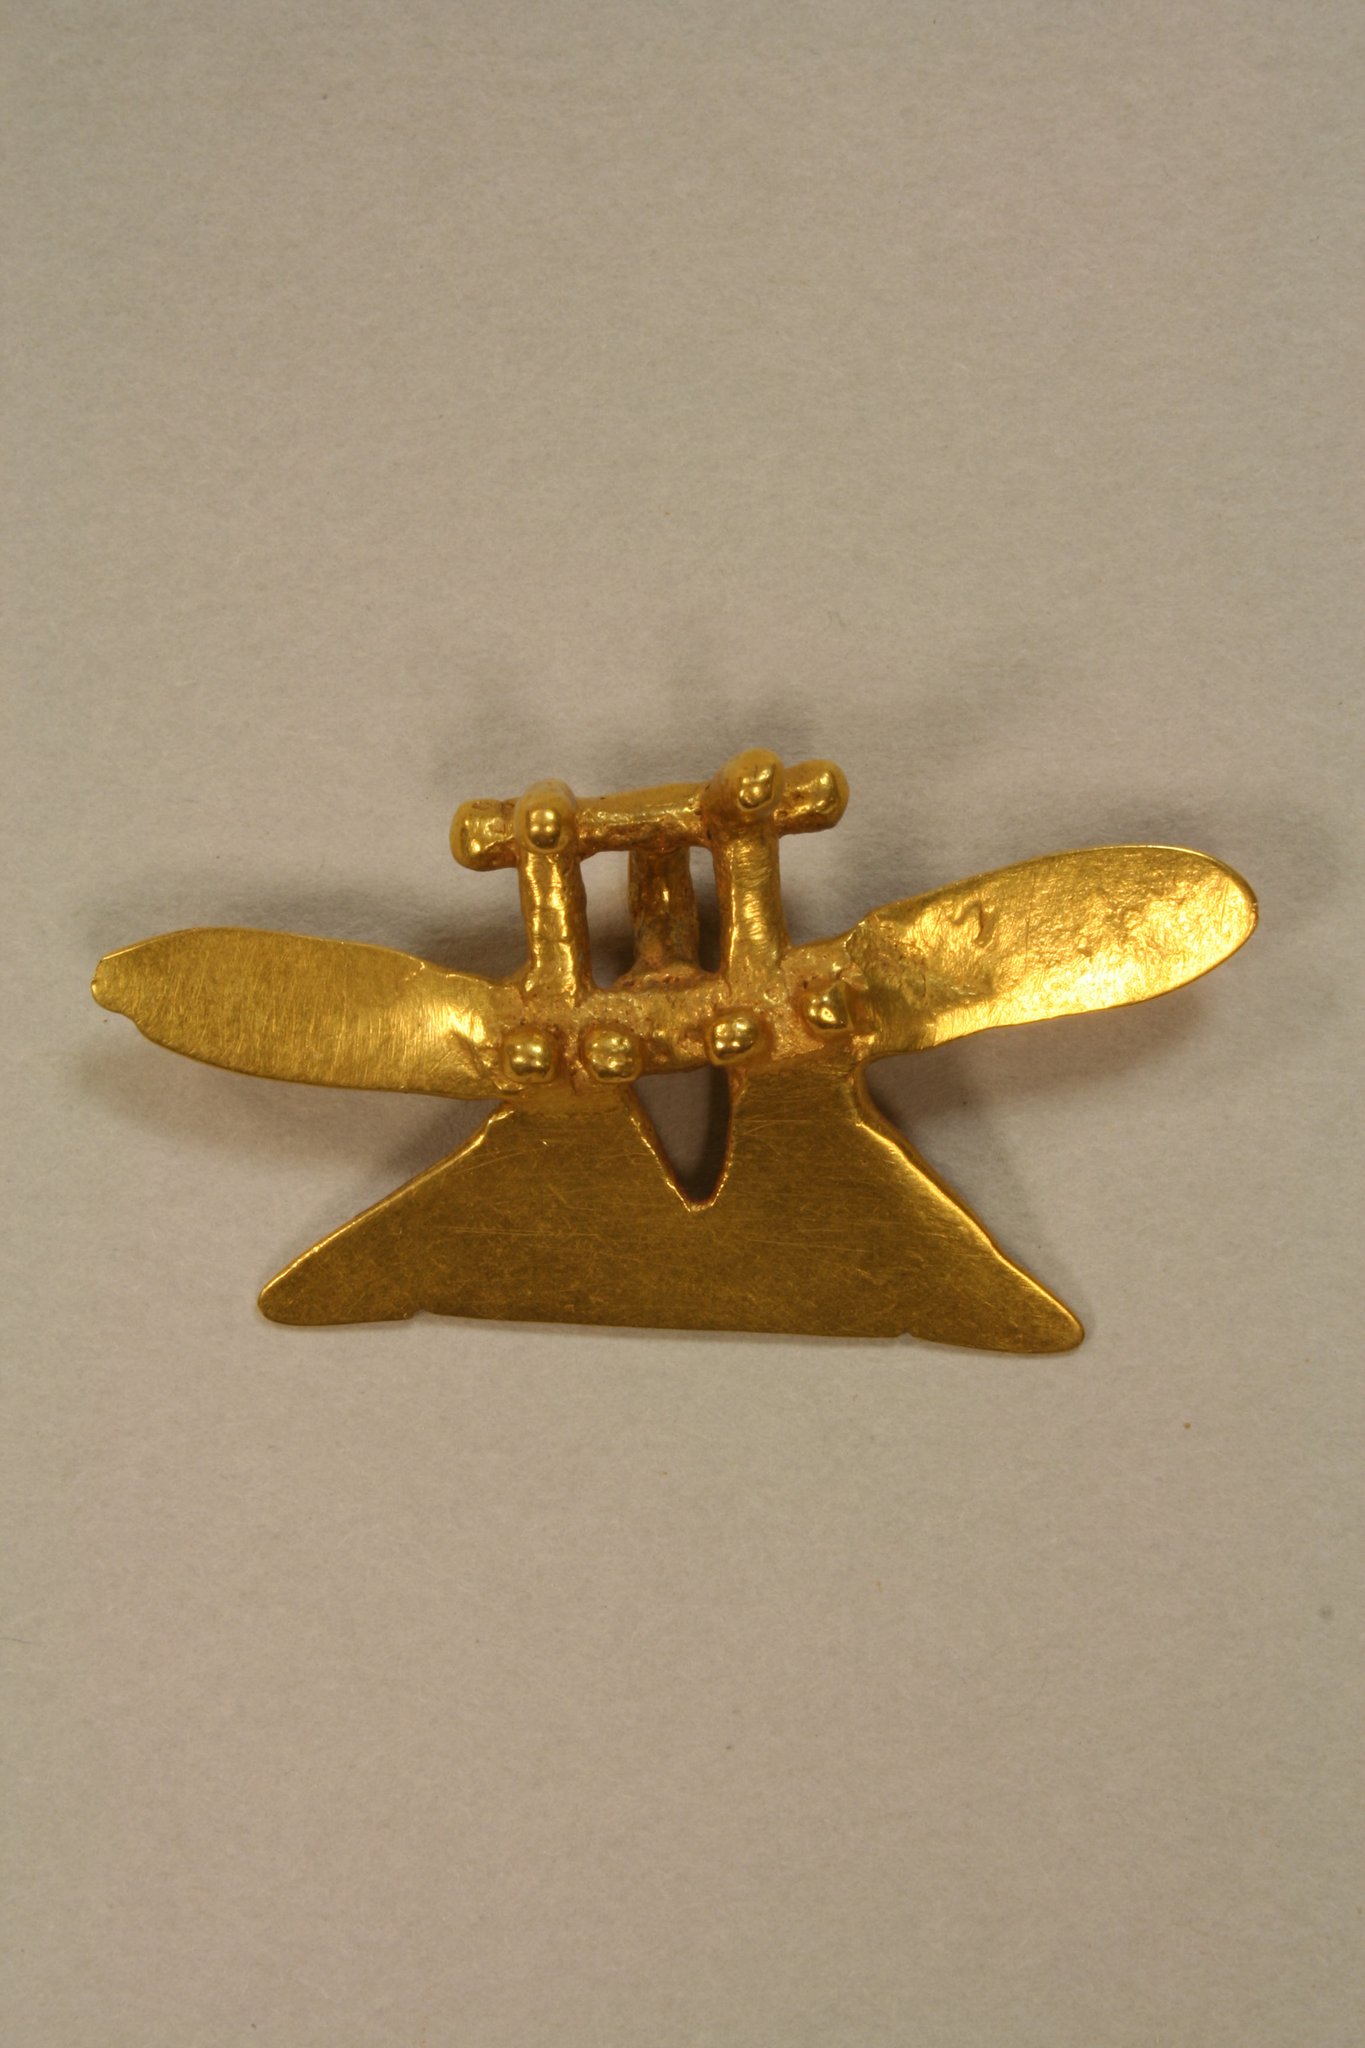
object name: pendant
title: Eagle Pendant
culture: atlantic watershed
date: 701-1600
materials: gold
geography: costa rica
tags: eagles